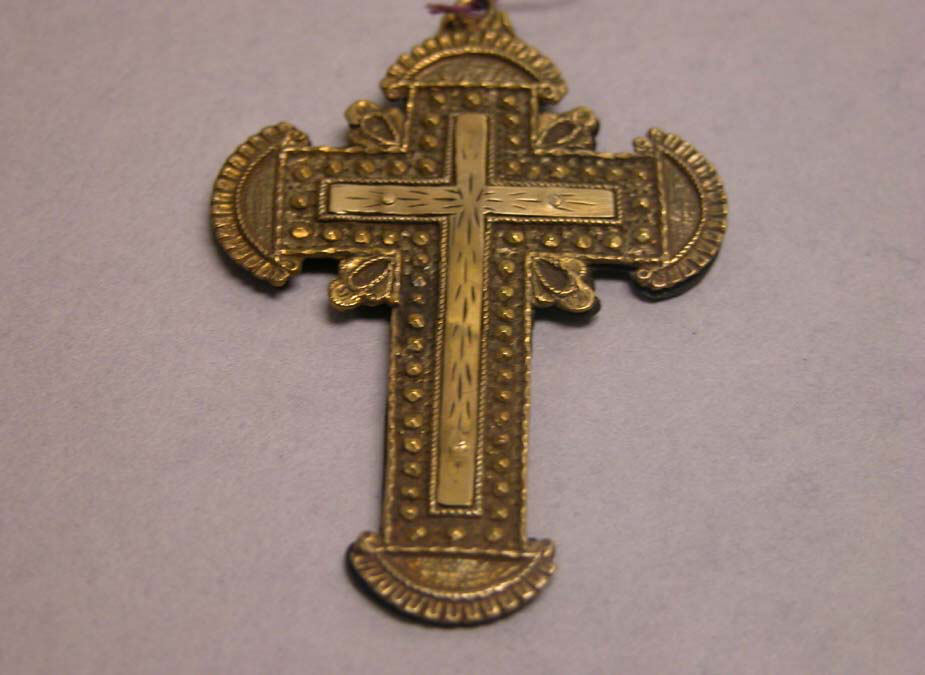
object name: cross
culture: filipino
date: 1601-1900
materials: gold